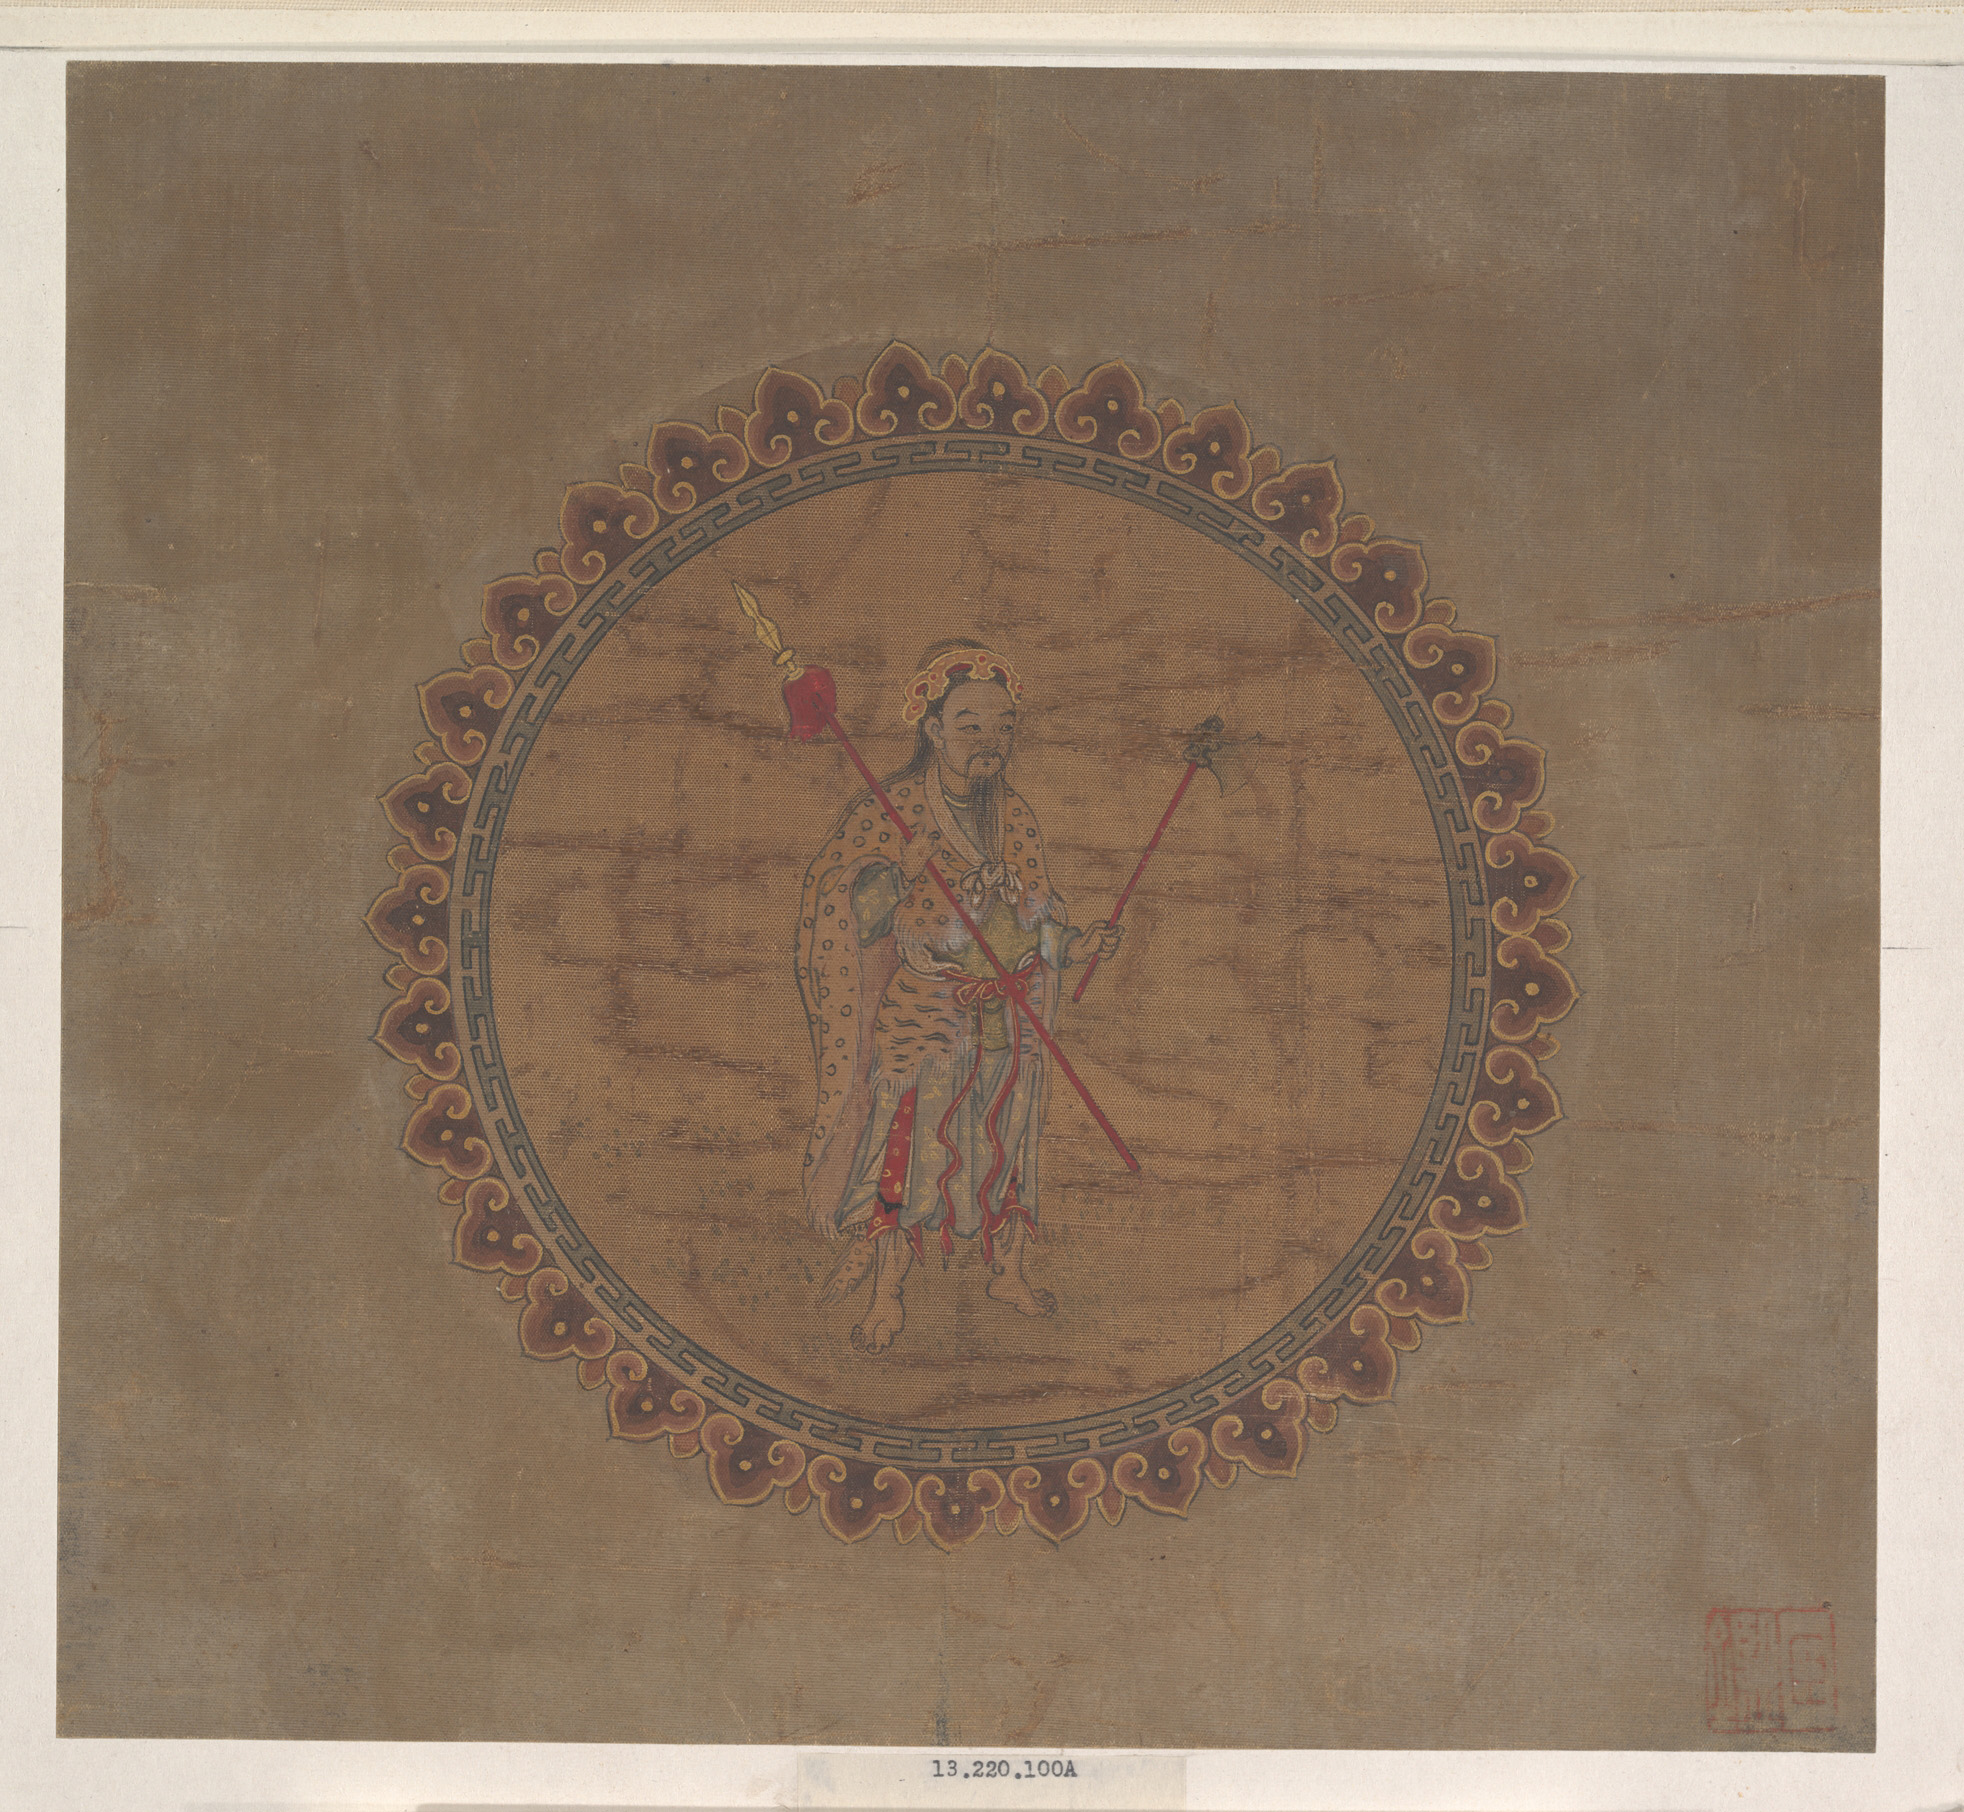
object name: album leaf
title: Twelve Designs for Circular Mirror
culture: chinese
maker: yi yuanji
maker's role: artist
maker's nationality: chinese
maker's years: 966-1066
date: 1368-1911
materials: ink, silk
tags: animals,men,mirrors